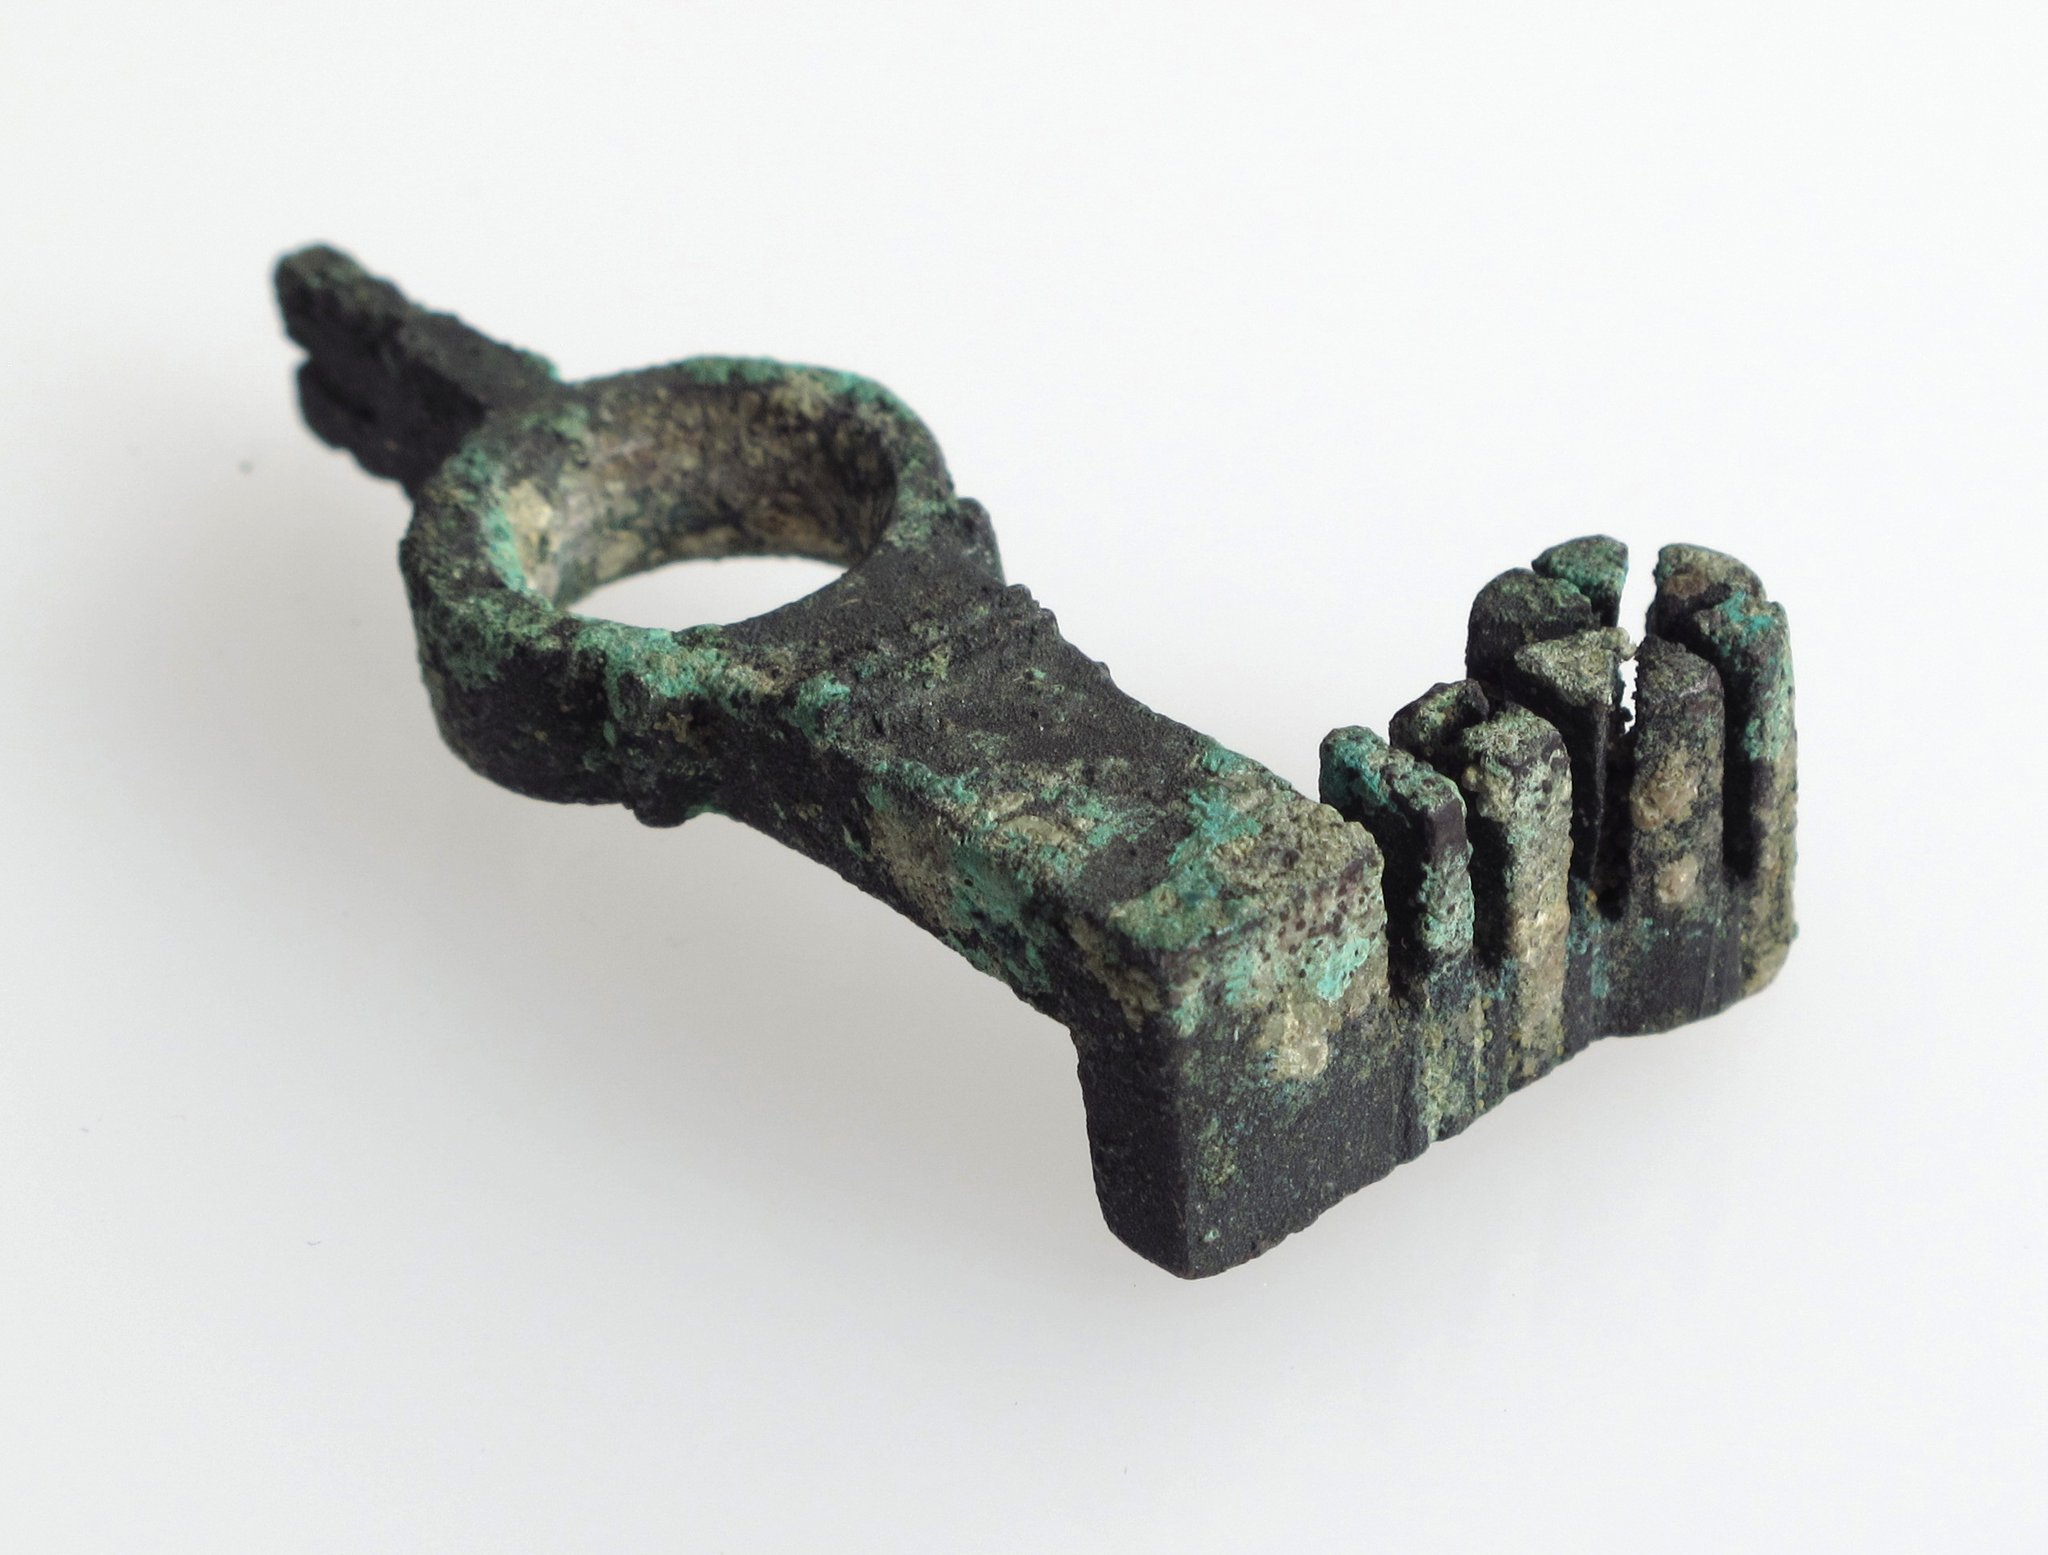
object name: key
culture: roman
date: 1-300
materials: copper alloy, iron